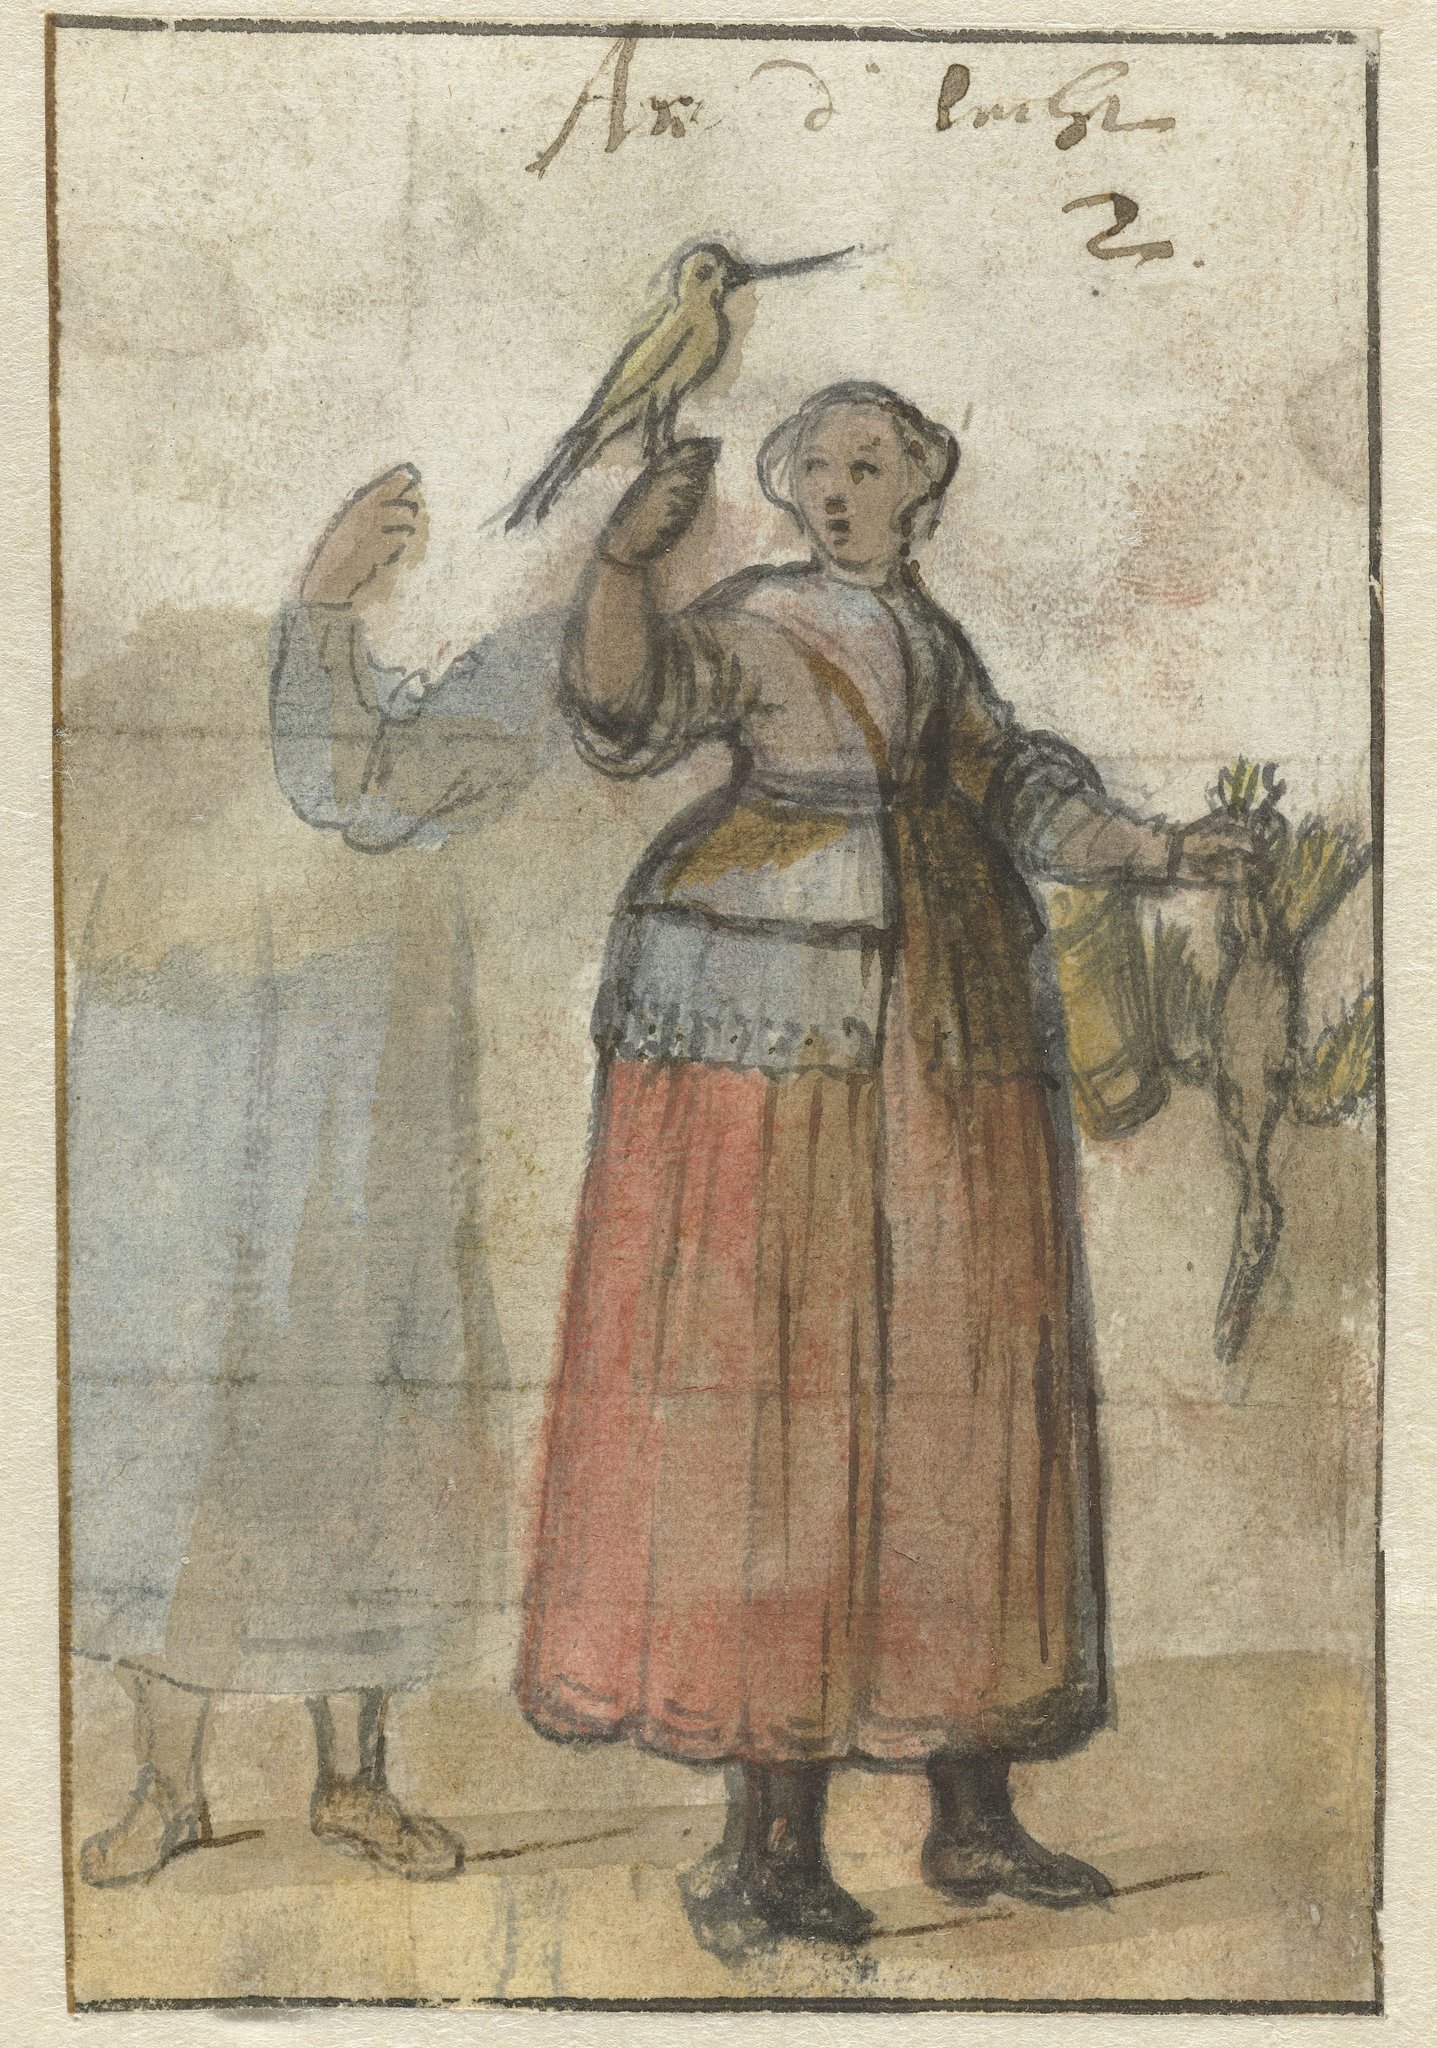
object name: drawing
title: Lucht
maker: Anonymous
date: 1600-1699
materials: paper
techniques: brush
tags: air (one of the four elements), birds, meat; still life of meat, kitchen-maid, kitchen servant